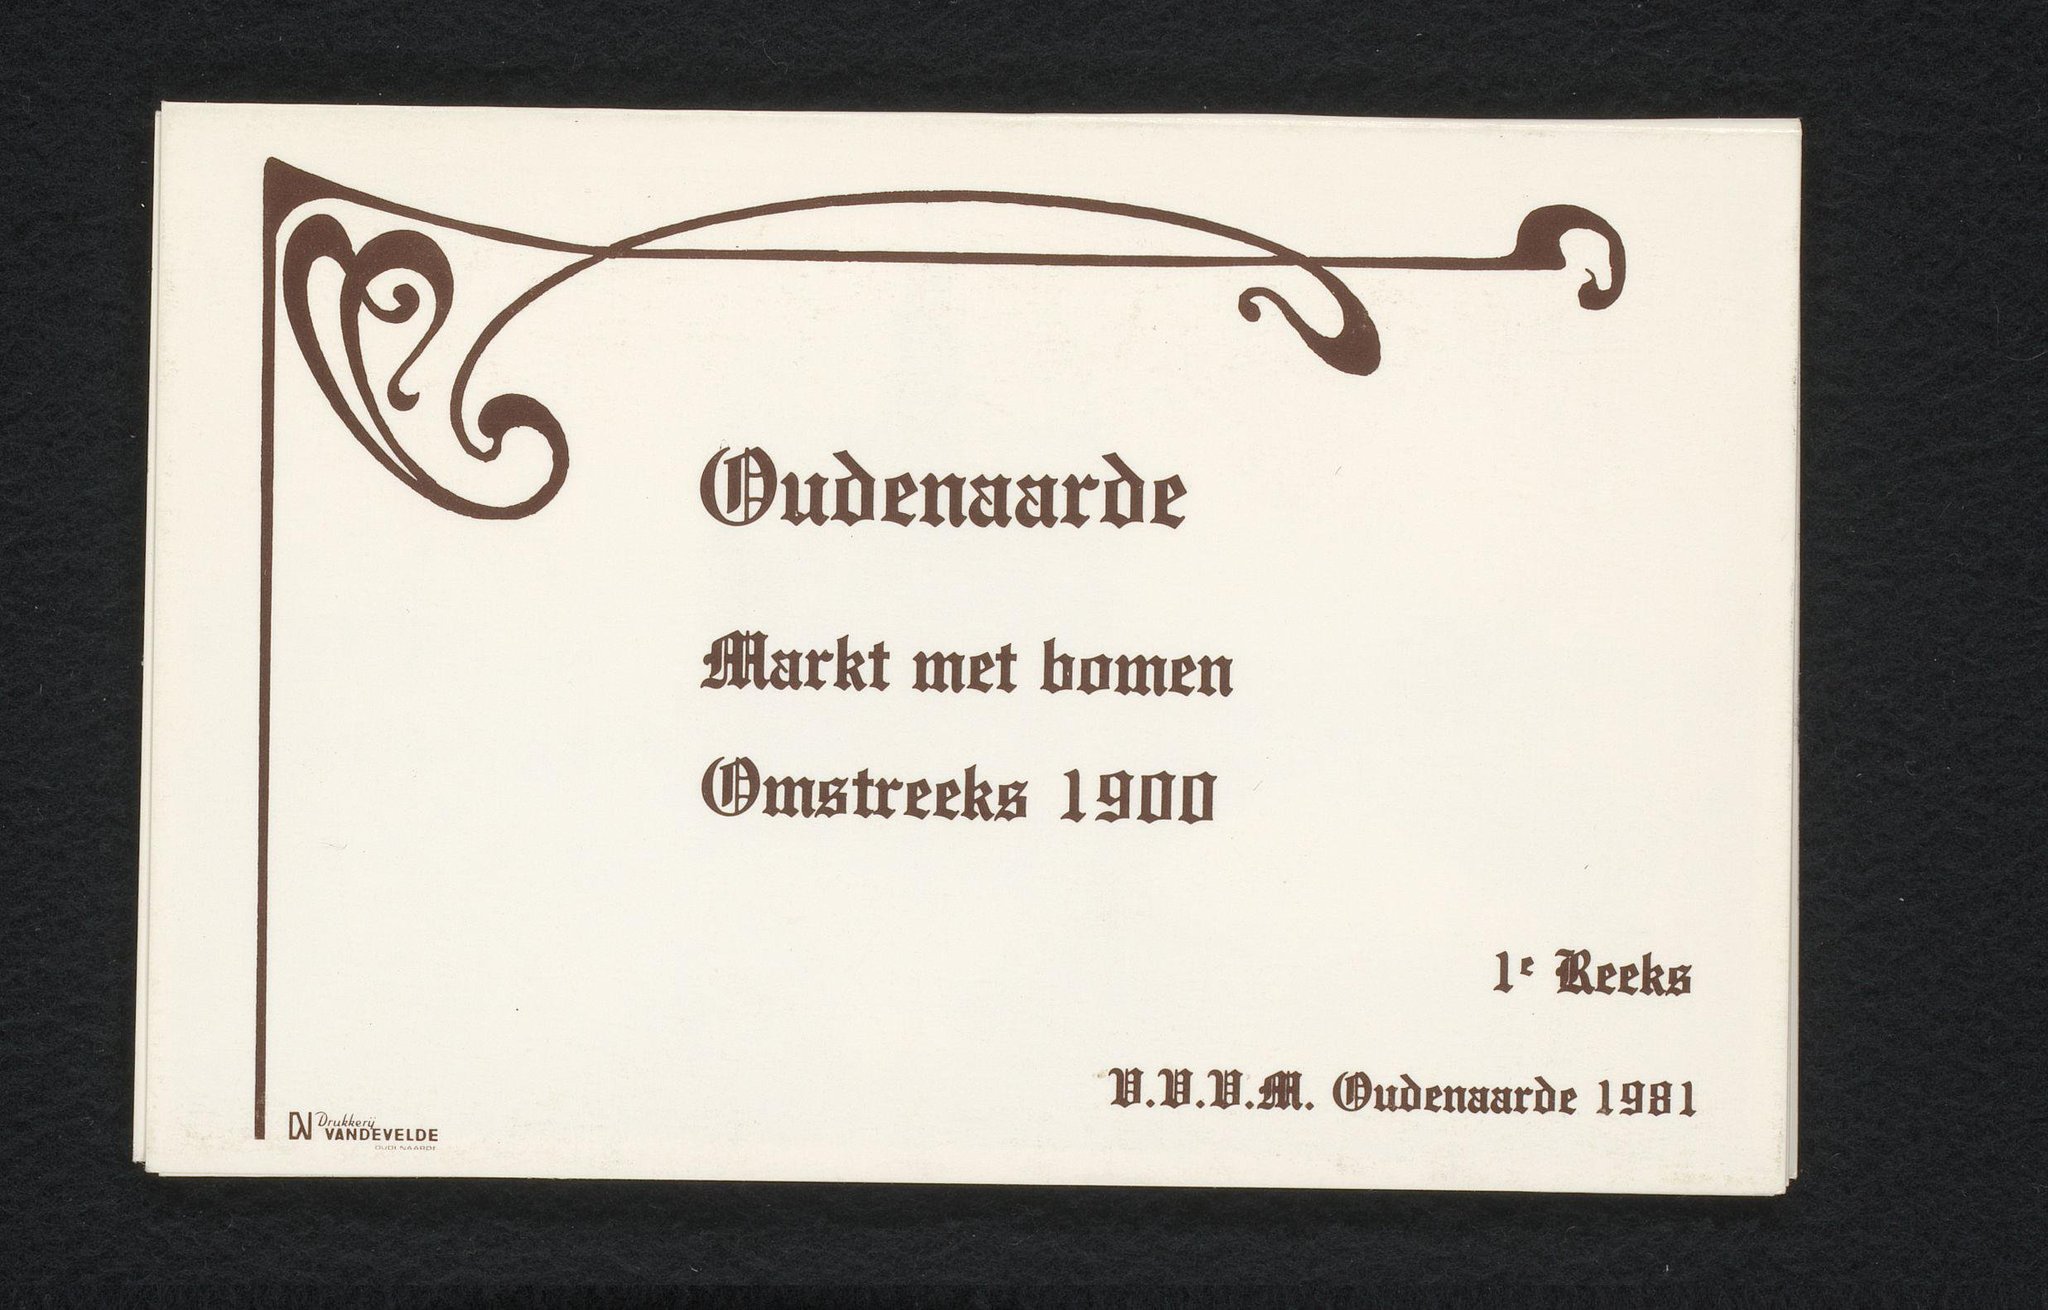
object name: photomechanical print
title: Markt met bomen omstreeks 1900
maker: Anonymous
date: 1981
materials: cardboard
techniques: letterpress printing, offset printed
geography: oudenaarde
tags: city-view, and landscape with man-made constructions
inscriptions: date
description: Dit leporelloalbum bevat reproducties van oudere prentbriefkaarten.